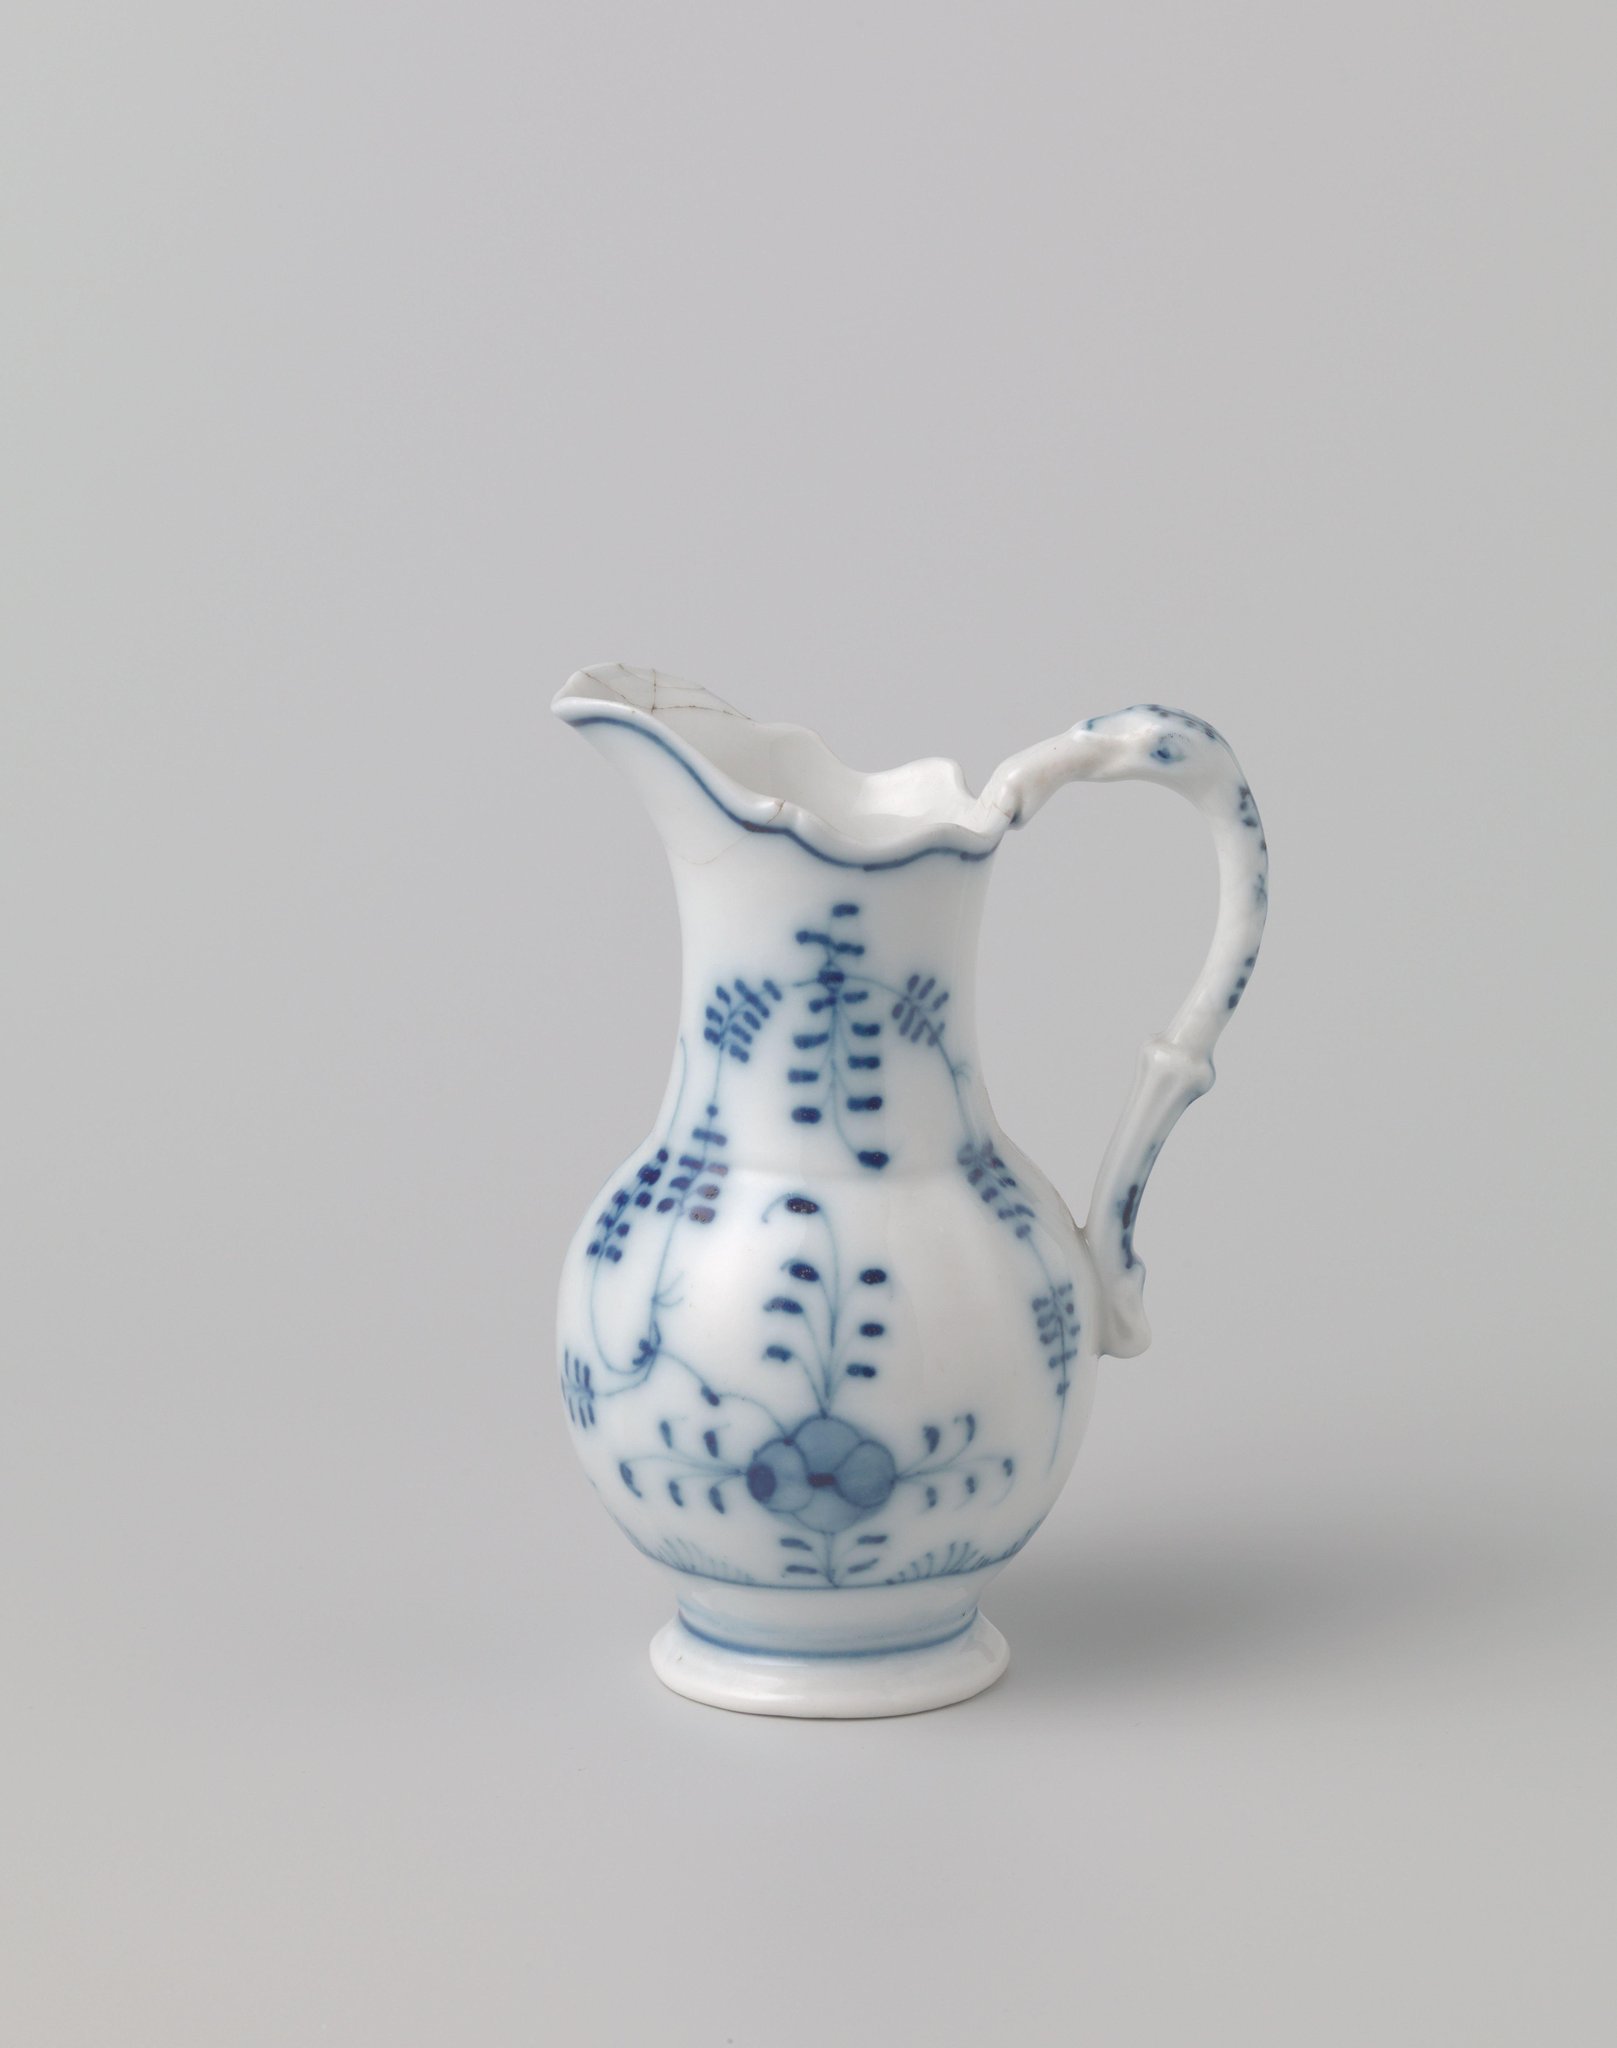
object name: miniature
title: Lampetkan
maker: Anonymous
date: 1775-1800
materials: ceramic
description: Lampetkan met blauw Saksisch patroon, ongemerkt.